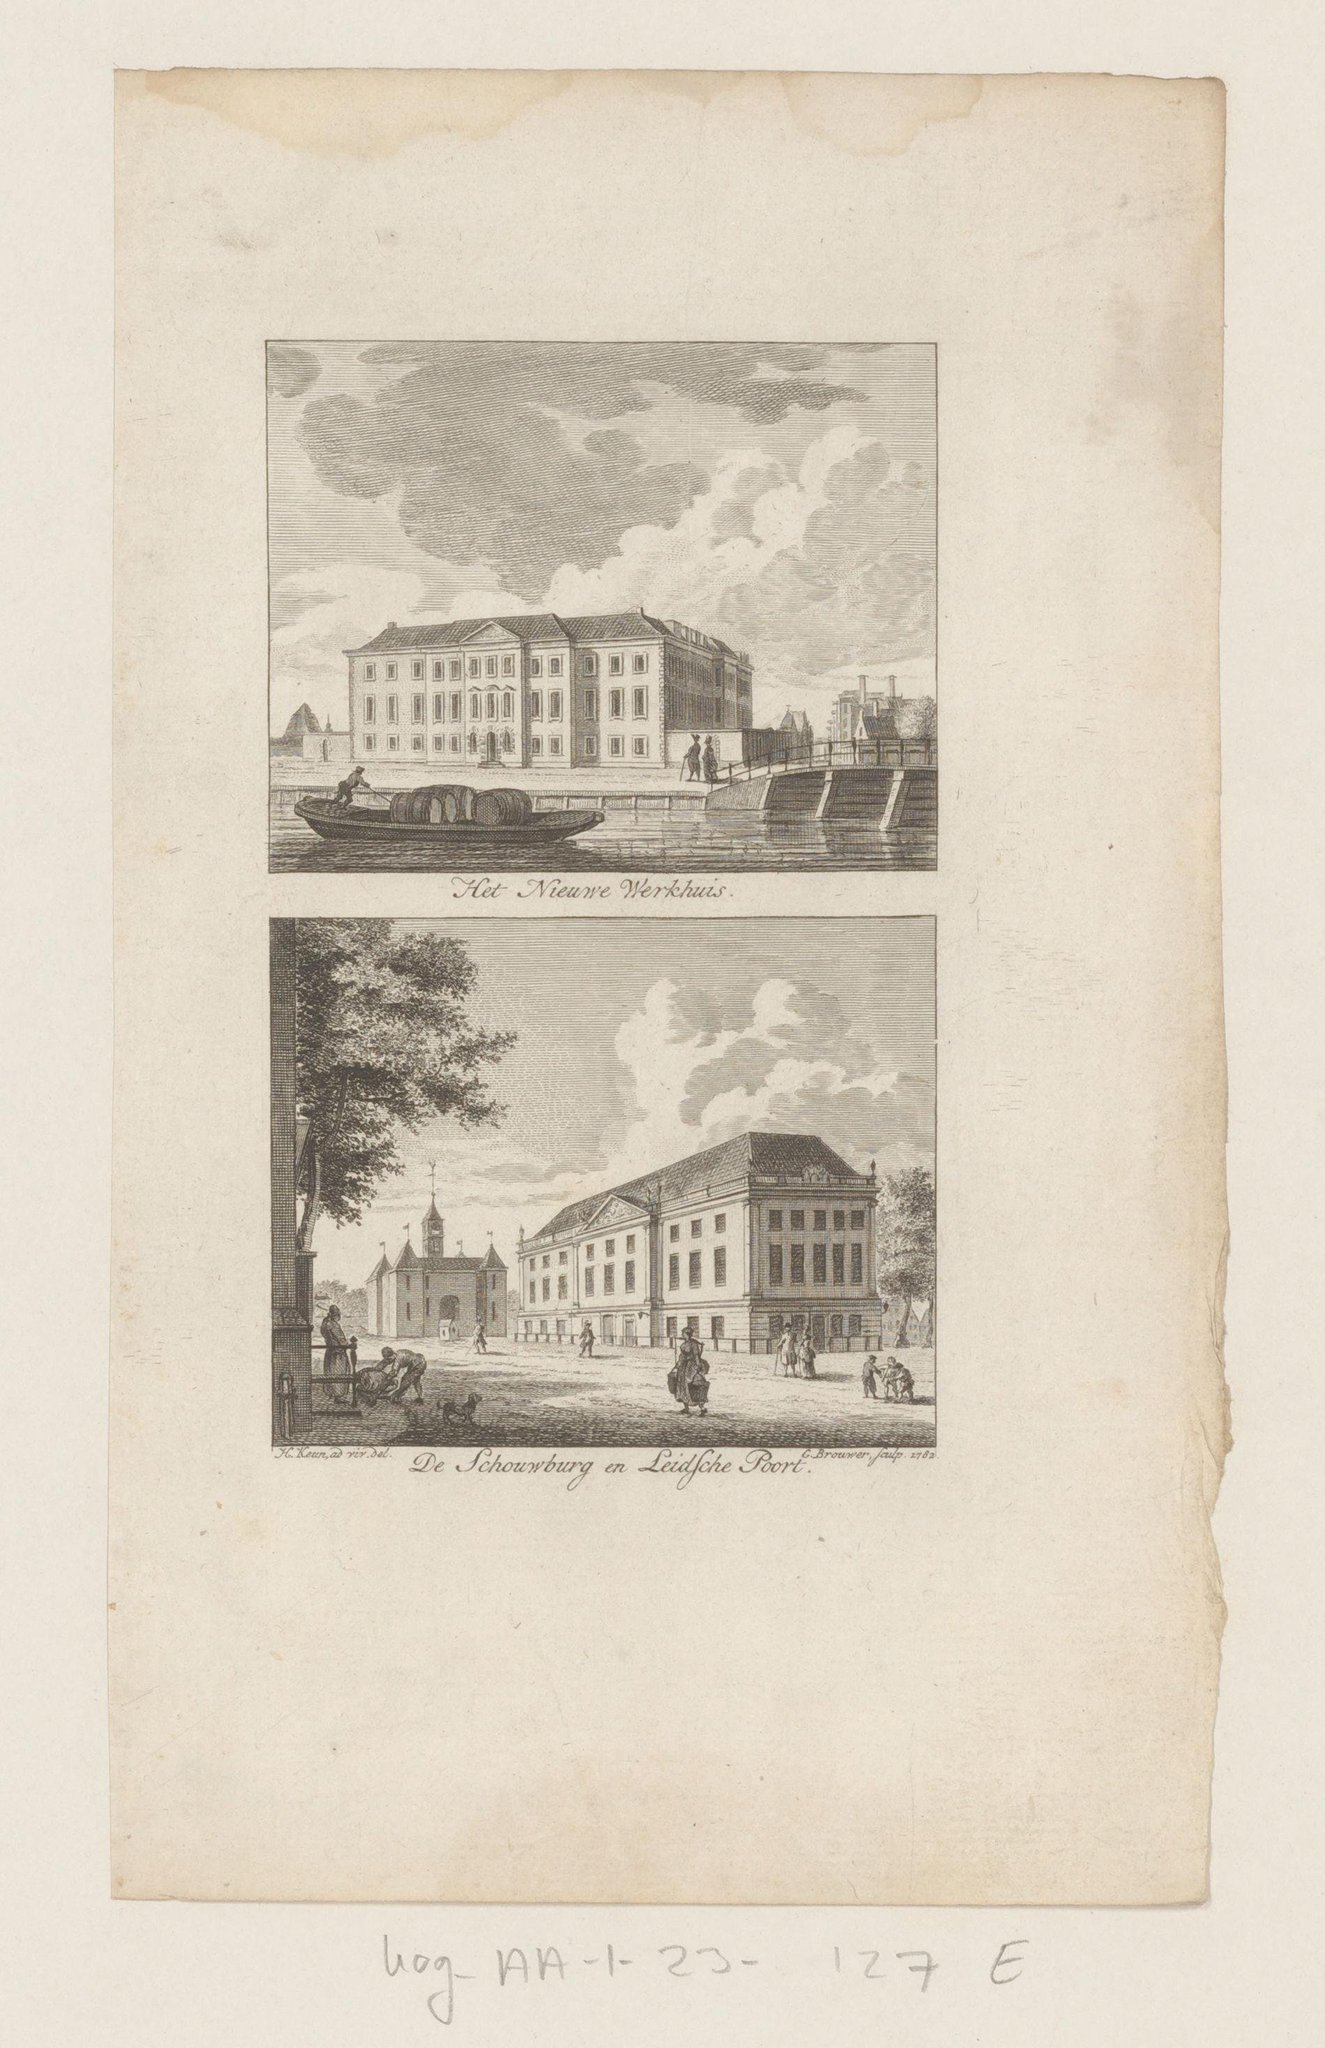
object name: print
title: Het Nieuwe Werkhuis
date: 1782-1788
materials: paper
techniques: etching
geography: northern netherlands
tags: prison, jail, theatre (building), gate, entrance, canals, waters (in city), workhouse, penal camp, penitentiary, chain gang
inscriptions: collector's mark: Lugt 1641b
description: Prent mogelijk uit: Beschryving van Amsterdam verkort. Amsterdam: Hendrik Gartman en Izaak de Jongh, 1782. Of uit: Beschryving van Amsterdam verkort. Amsterdam: Johannes Wessing Willemsz. en Johannes van der Hey, 1788.